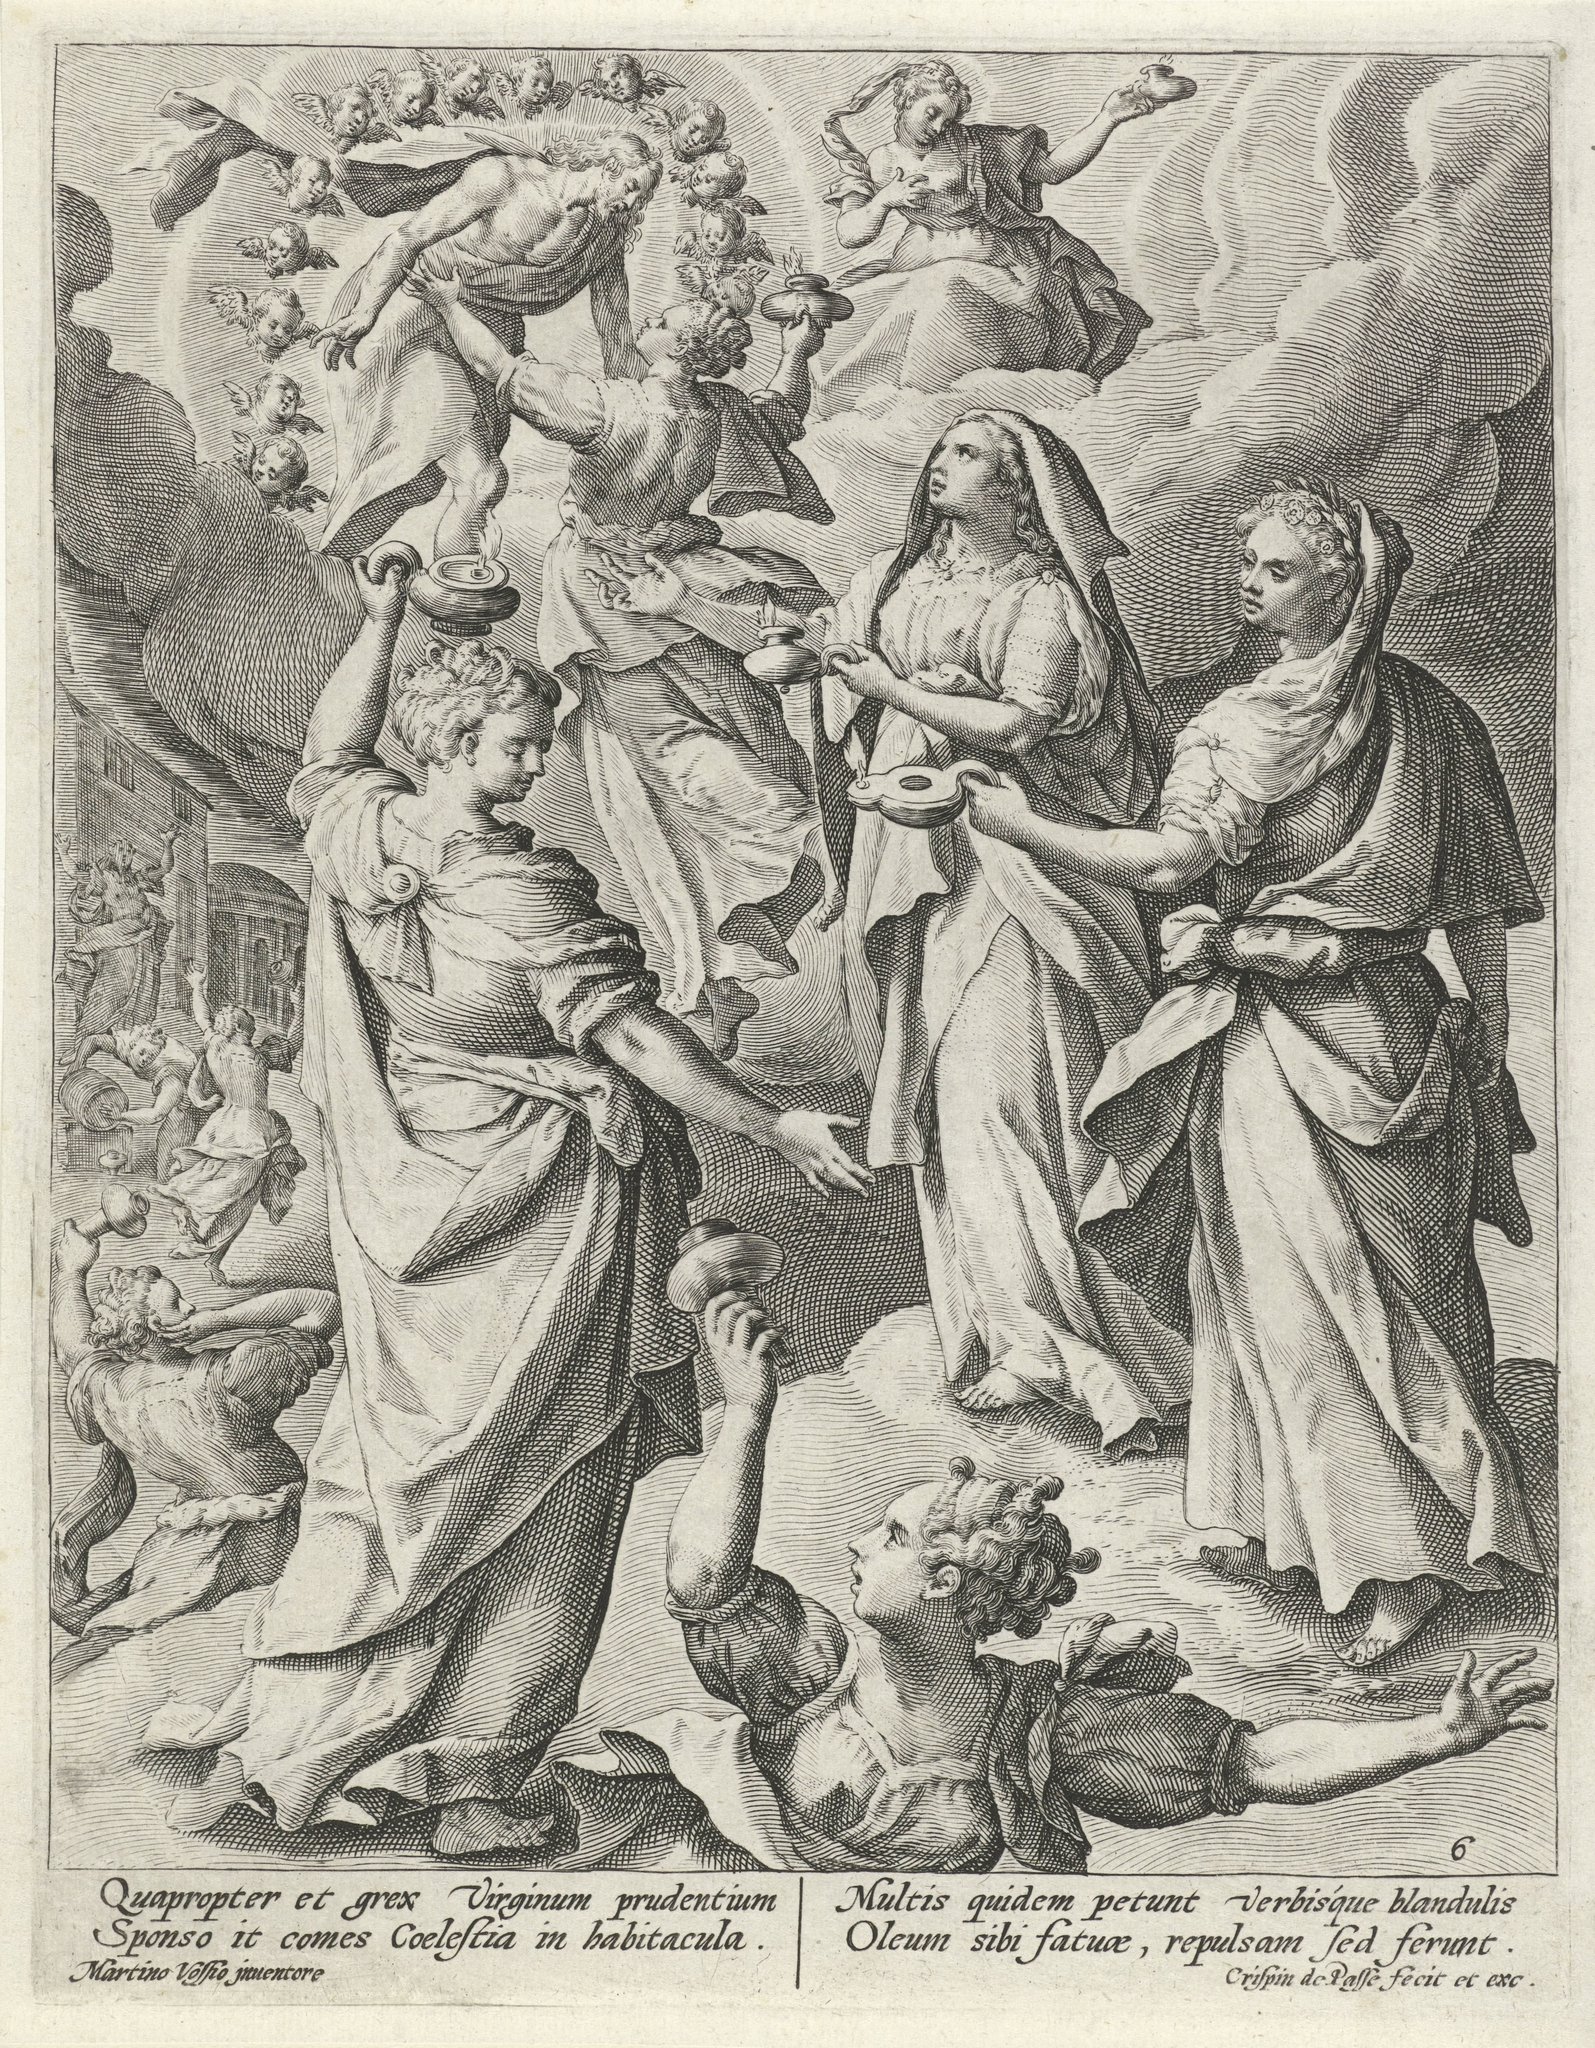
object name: print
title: De bruidegom ontvangt de vijf wijze maagden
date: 1589-1611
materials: paper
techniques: engraving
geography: cologne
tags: the wise virgins are let into the house with the bridegroom (christ); the foolish virgins are shut out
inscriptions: collector's mark: Lugt 2161, collector's mark: Lugt 2228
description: De bruidegom (Christus) ontvangt de vijf wijze maagden die klaarstaan voor het bruiloftsfeest. Op de achtergrond zijn de dwaze maagden op zoek naar olie om hun lampen bij te vullen. In de marge een vierregelig onderschrift, in twee kolommen, in het Latijn dat verwijst naar de maagden die in de hemel worden ontvangen en naar de maagden die buitengesloten worden.